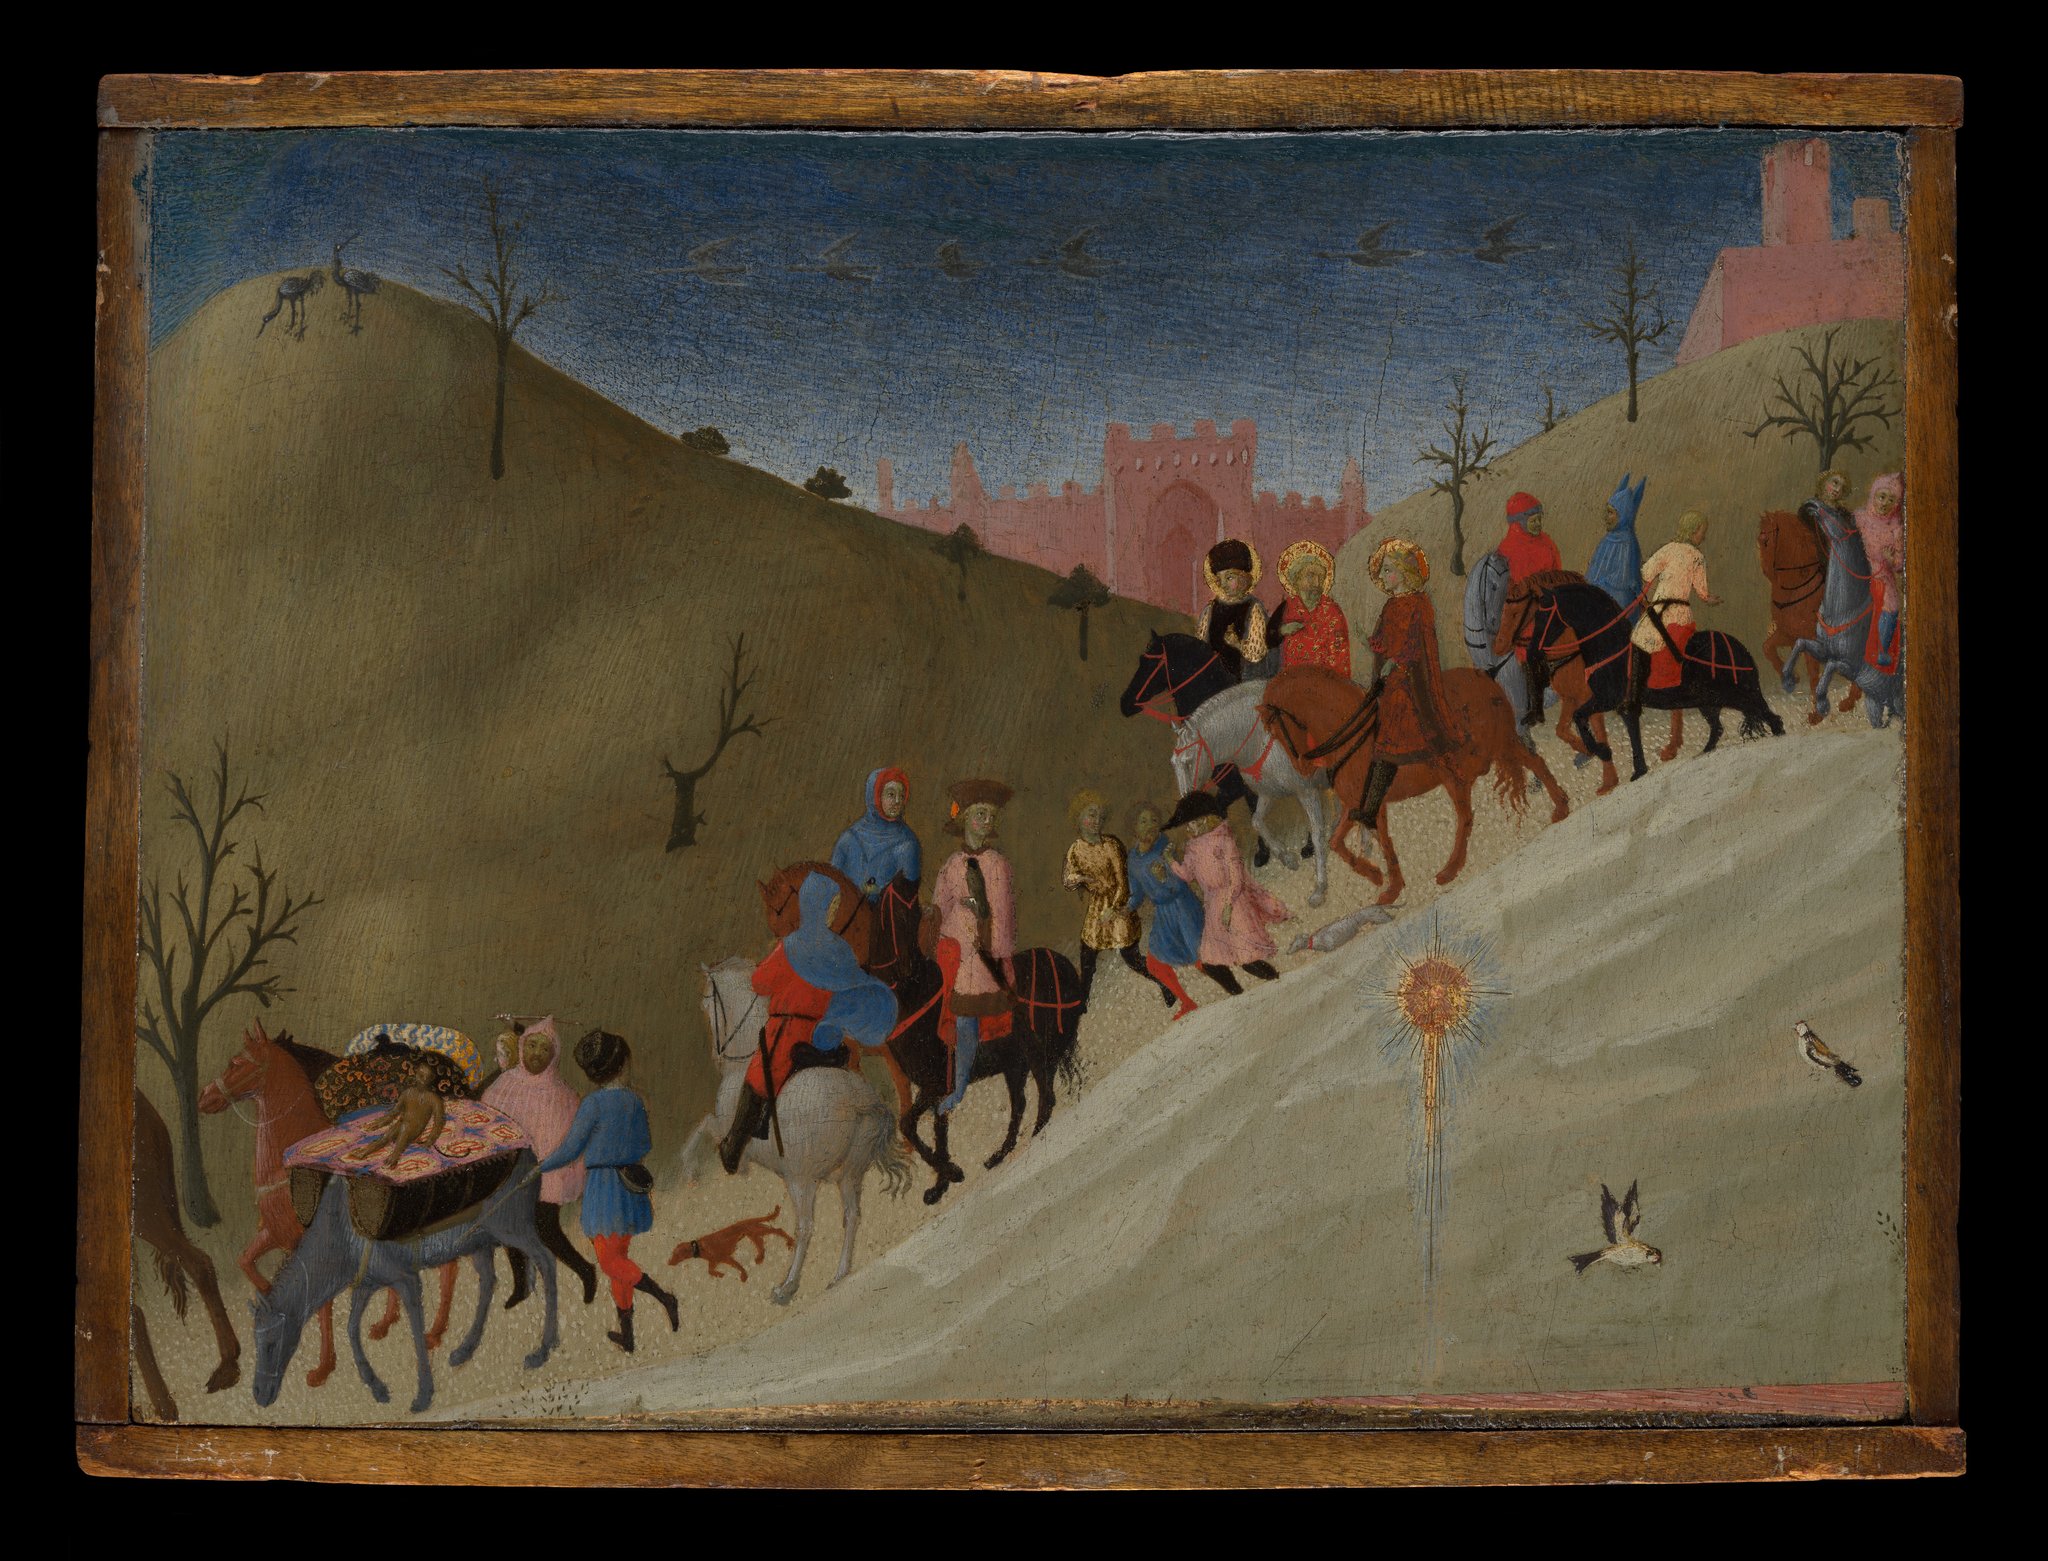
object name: painting fragment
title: The Journey of the Magi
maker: sassetta (stefano di giovanni)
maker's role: artist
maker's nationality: italian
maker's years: 1400-1450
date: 1433-1435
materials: gold, paint, wood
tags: men,horses,landscapes